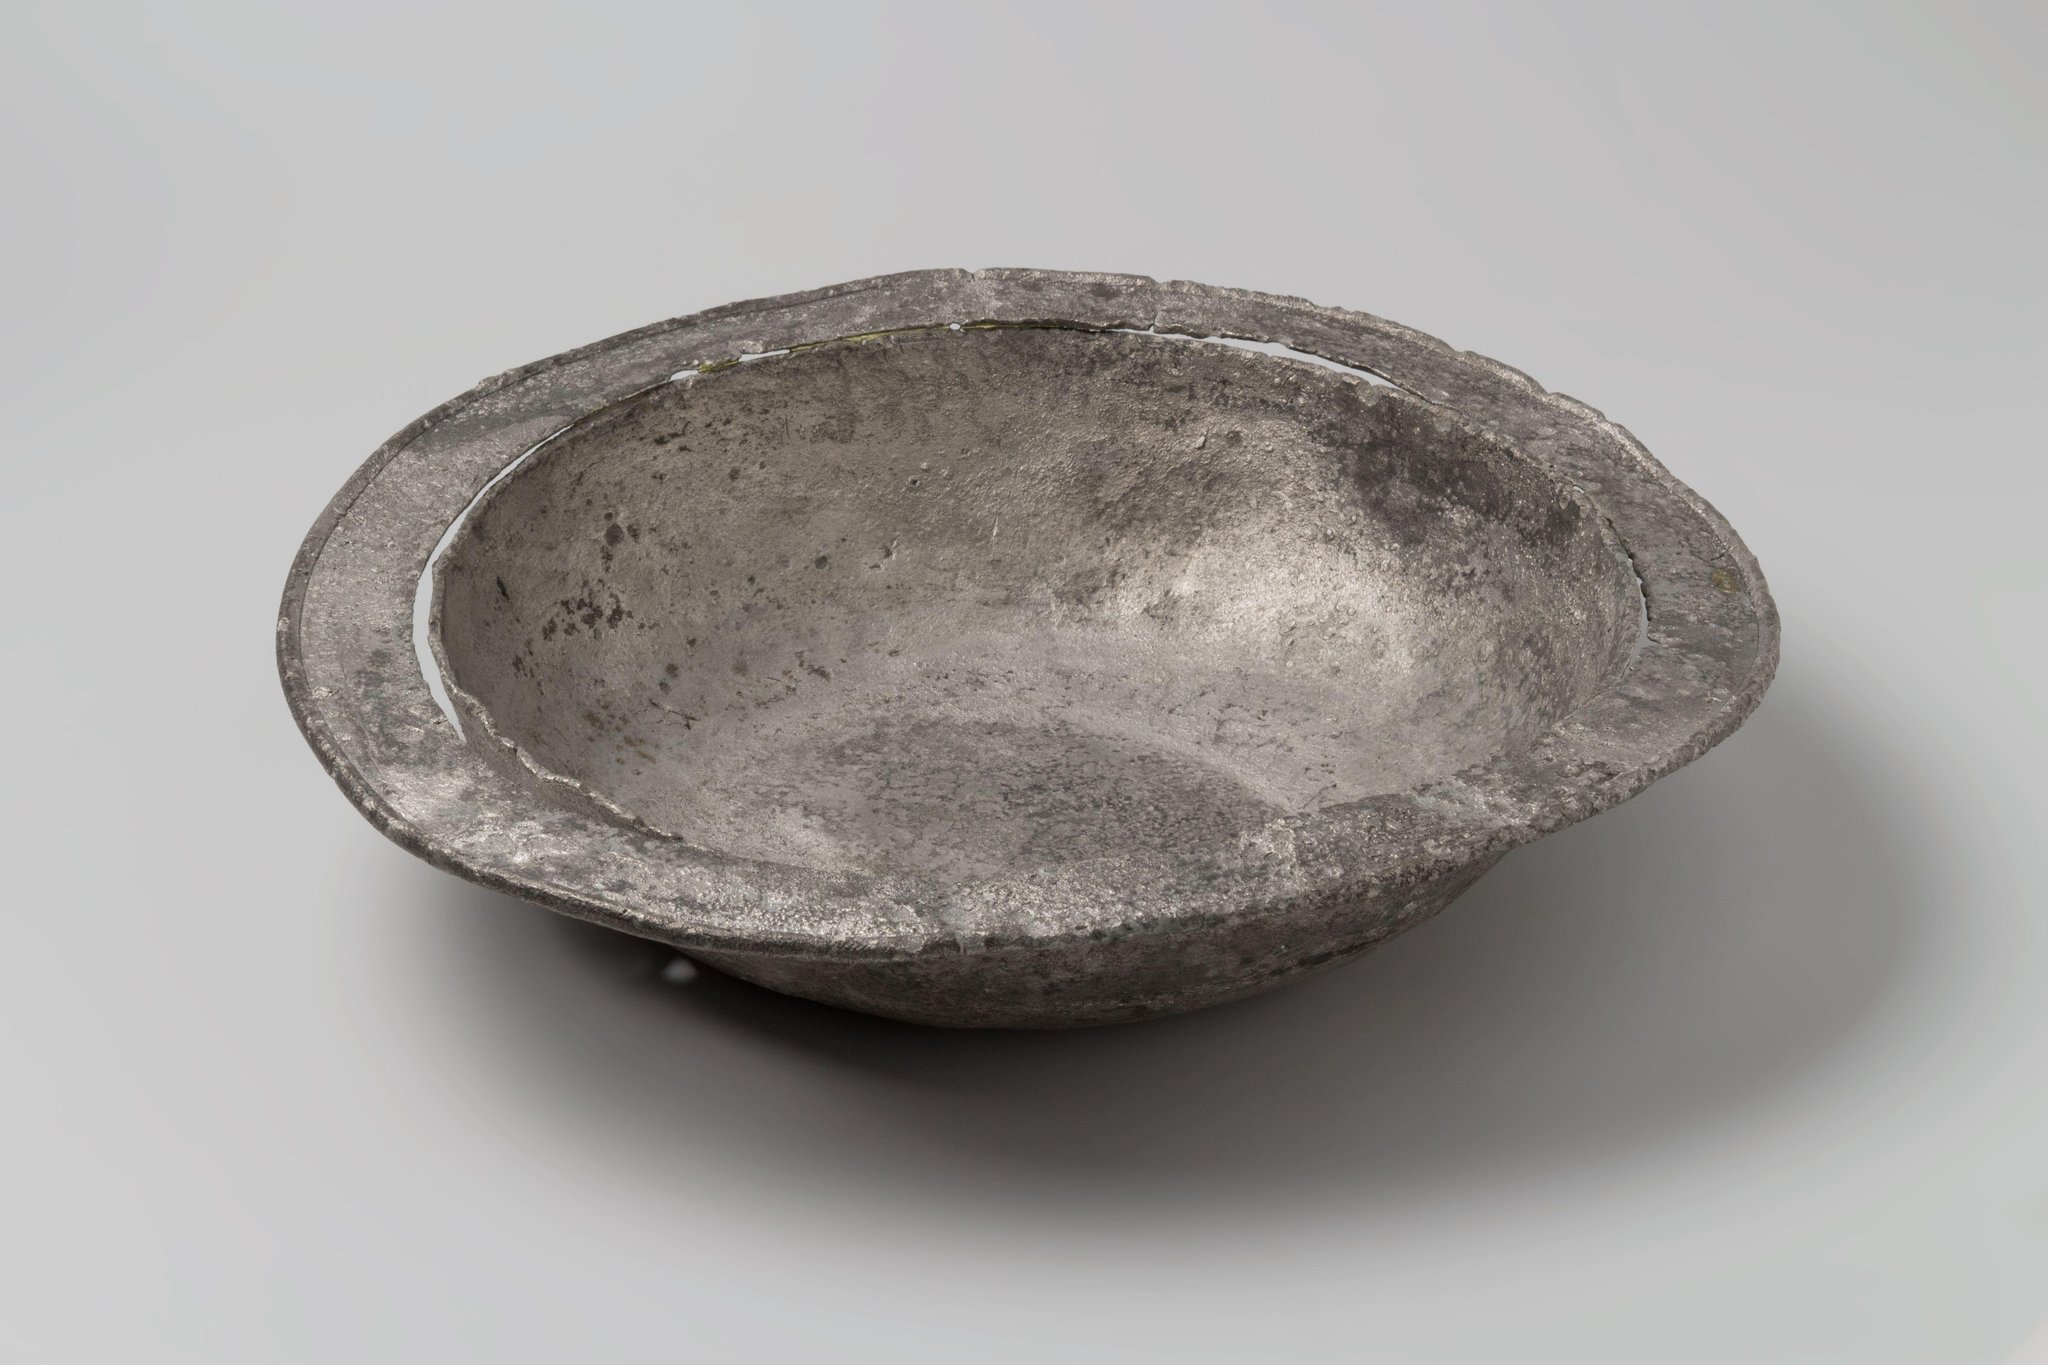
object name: plate dish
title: Tinnen bord uit het wrak van de Oost-Indiëvaarder Hollandia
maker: Anonymous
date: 1700-1743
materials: tin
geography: netherlands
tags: verenigde oostindische compagnie, hollandia (schip), annet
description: Plate, (2) fragm (1), eroded; circular convex bowl with flat base (c.27-27.5d, 7h), overhanging horizontal single-reeded rim (c.32.5-34.5d, 3w, 0.3t).